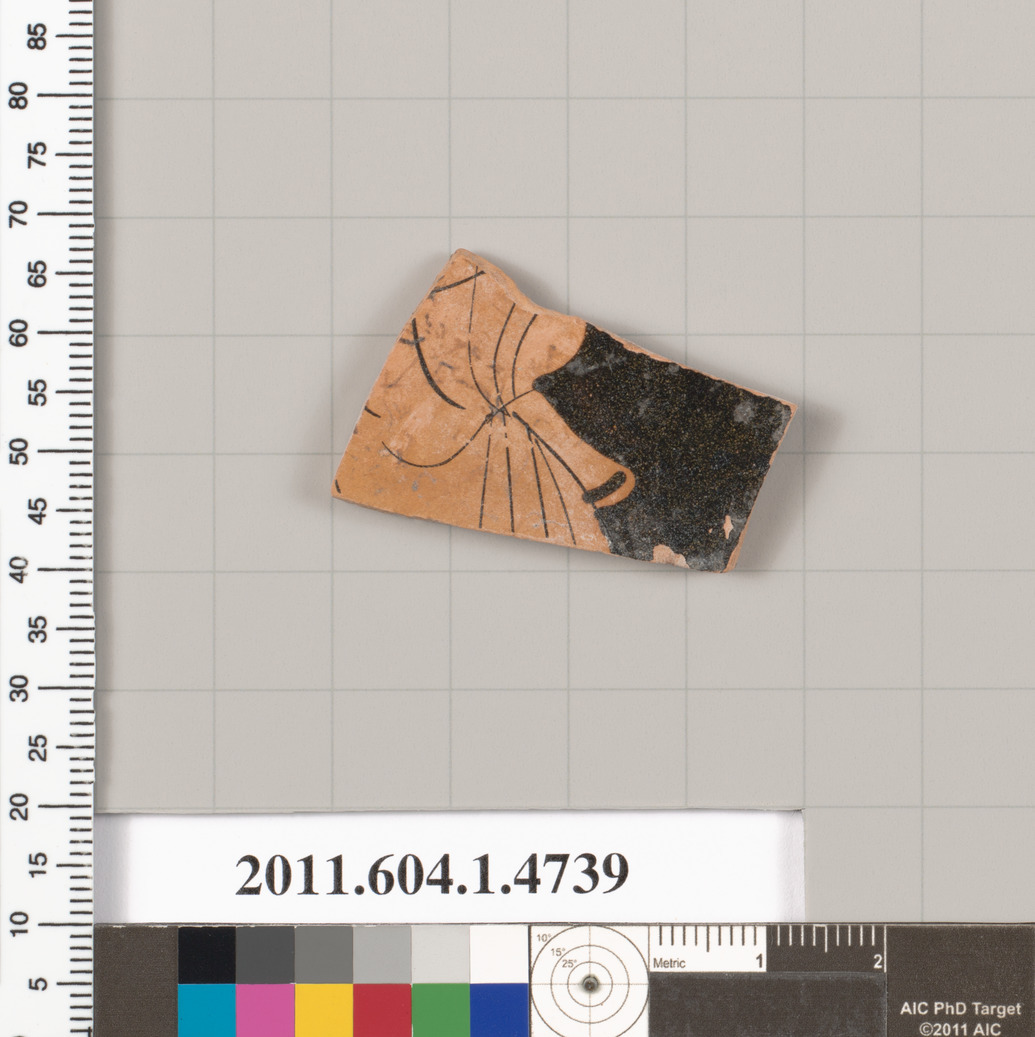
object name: kylix fragment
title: Terracotta fragment of a kylix (drinking cup)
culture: greek, attic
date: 475-451 BCE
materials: terracotta